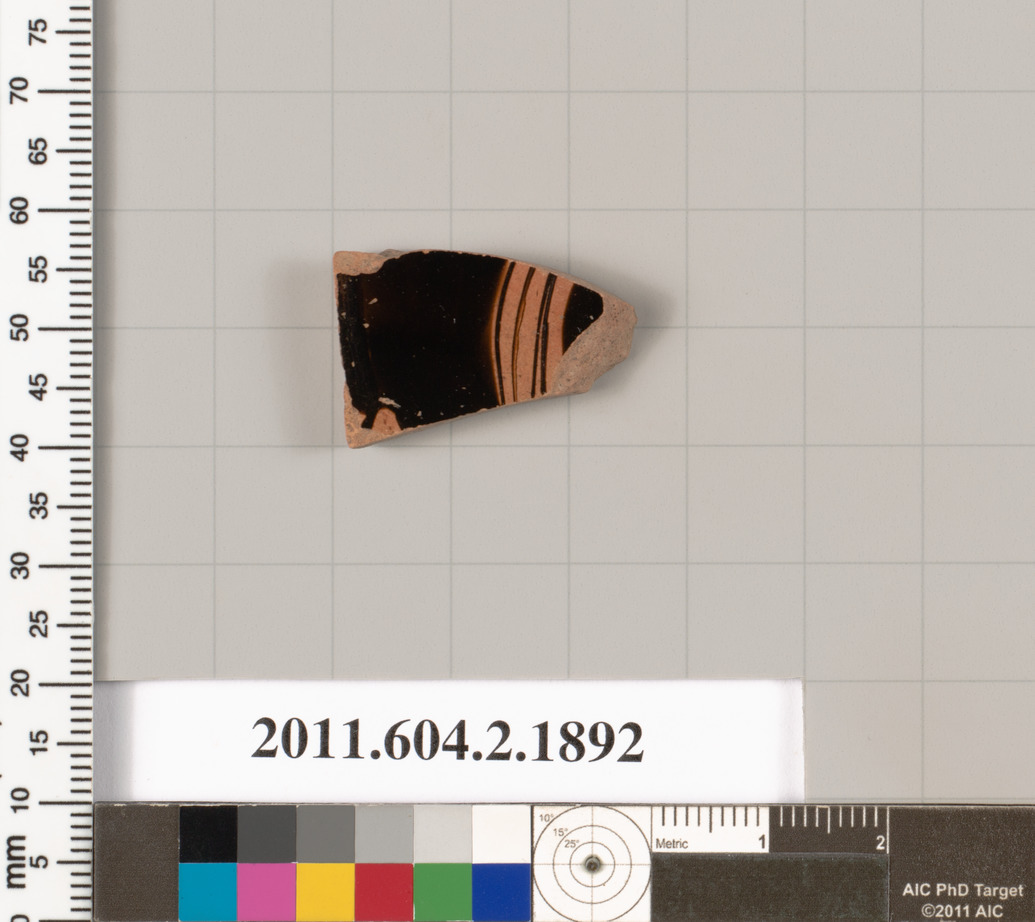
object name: skyphos fragment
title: Terracotta fragment of a skyphos (deep drinking cup)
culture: greek, attic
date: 450-426 BCE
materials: terracotta